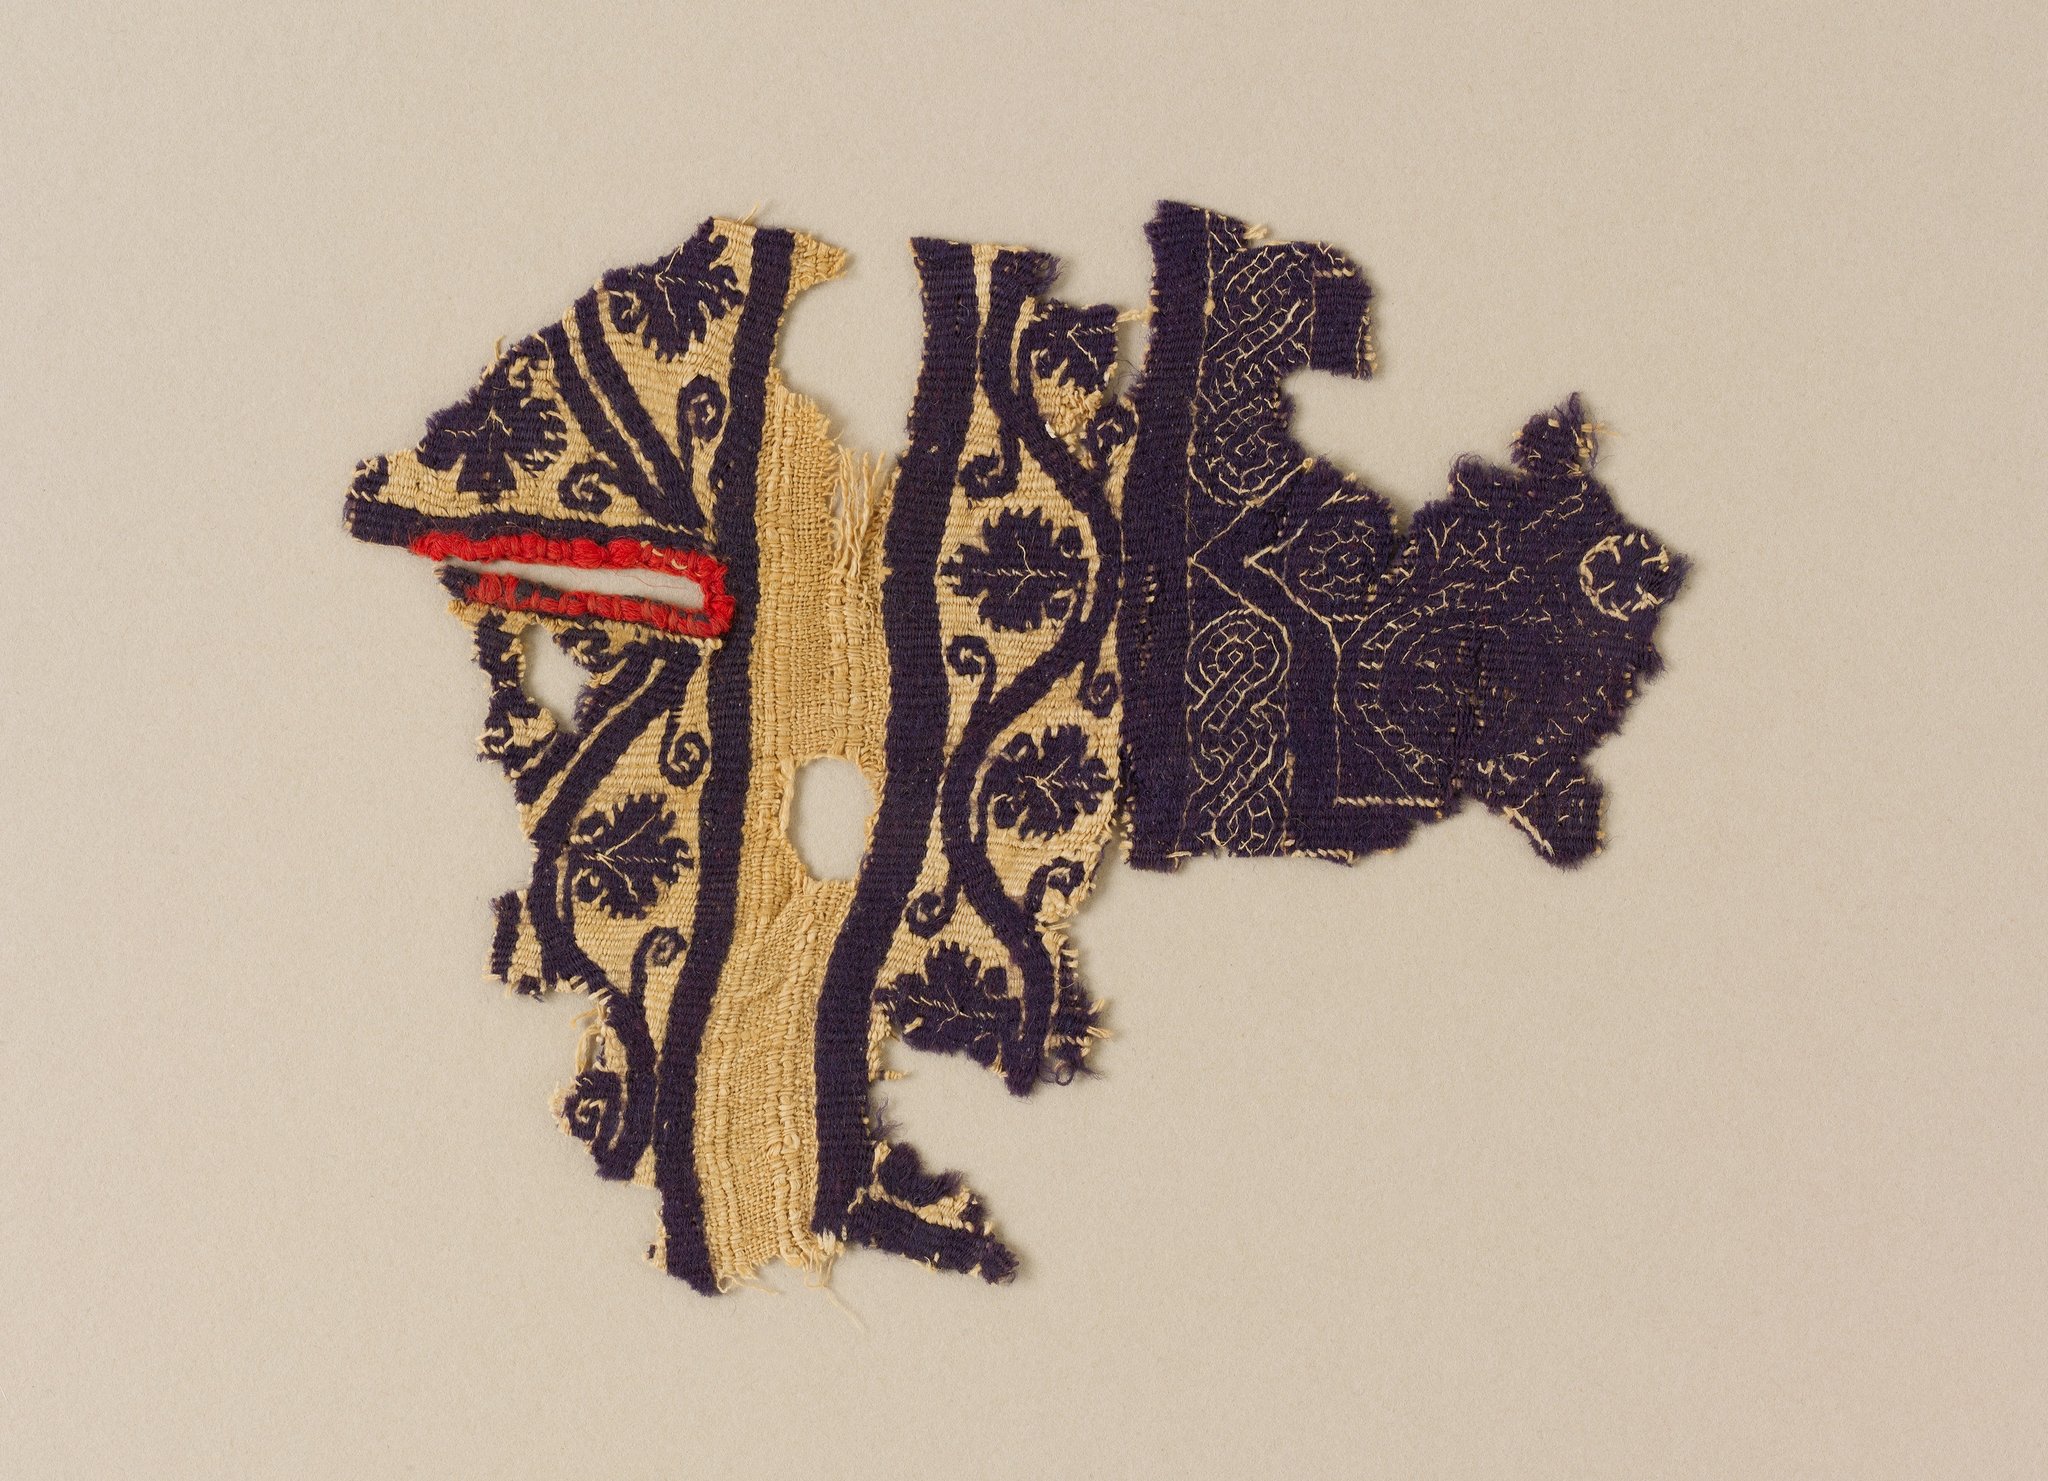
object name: textile fragment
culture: coptic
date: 300-600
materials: linen, wool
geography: egypt